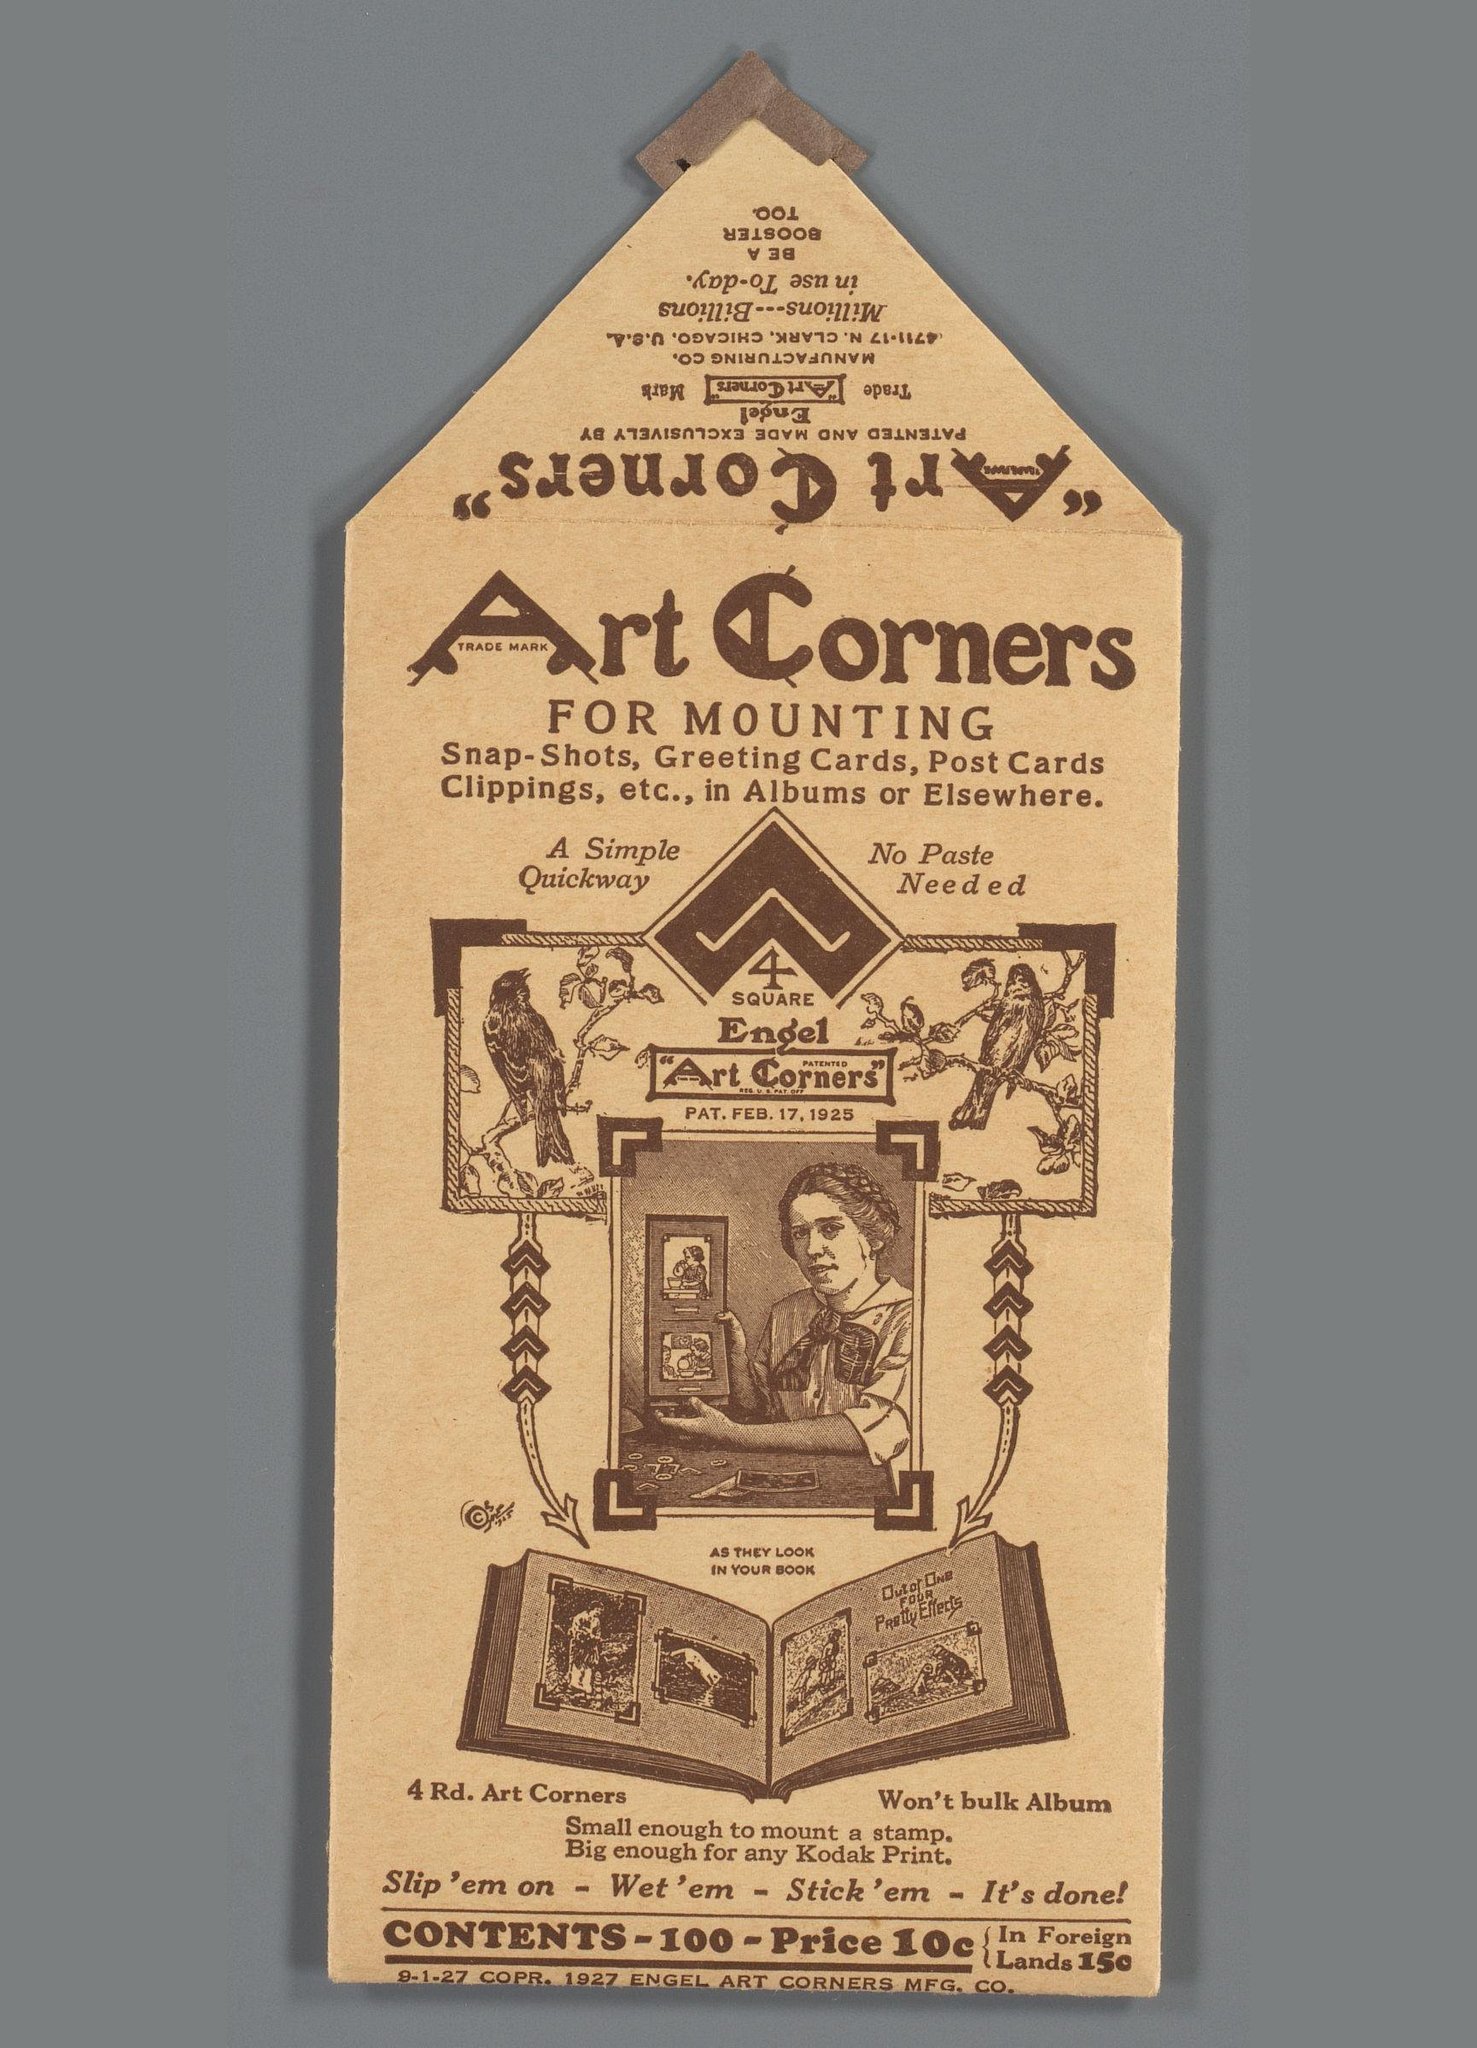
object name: document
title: Zakje met fotohoekjes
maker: j. van der zanden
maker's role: fotograaf, fotohandel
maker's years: 1885-1965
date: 1925-1940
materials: paper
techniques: lithograph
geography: chicago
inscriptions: name: ‘J. van der Zanden Fotografisch Magazijn / Breestraat 141 ... Leiden’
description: Zakje met fotohoekjes van het merk Art Corners.